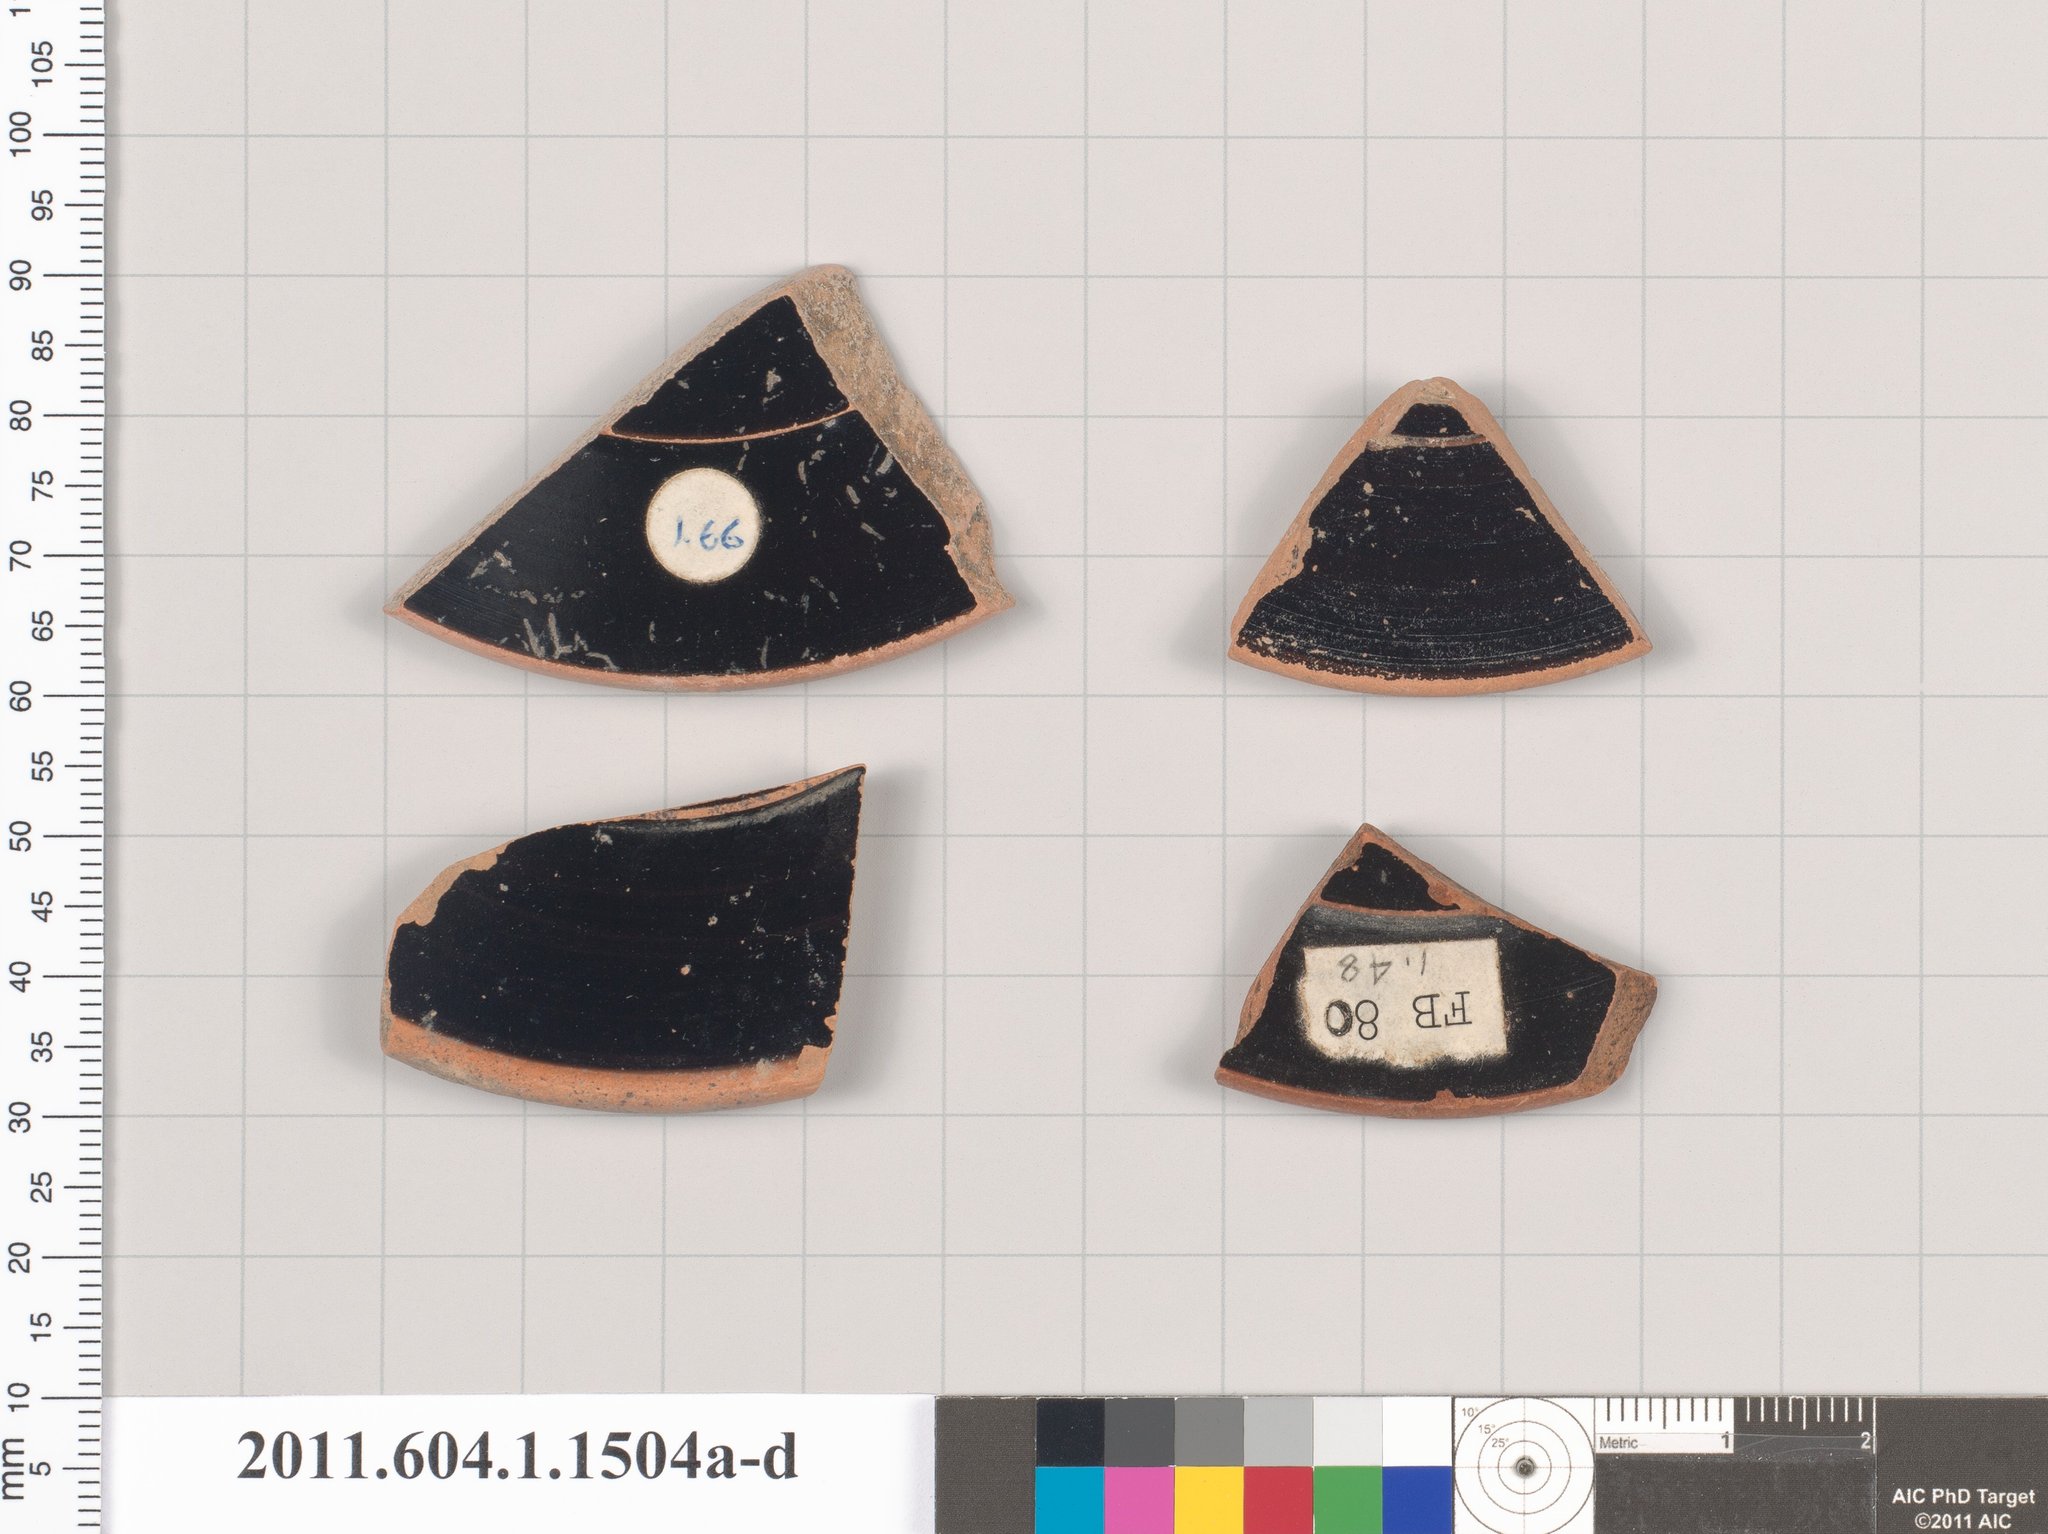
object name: kylix fragment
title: Terracotta fragments of kylikes (drinking cups)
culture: greek, attic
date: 500-401 BCE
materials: terracotta